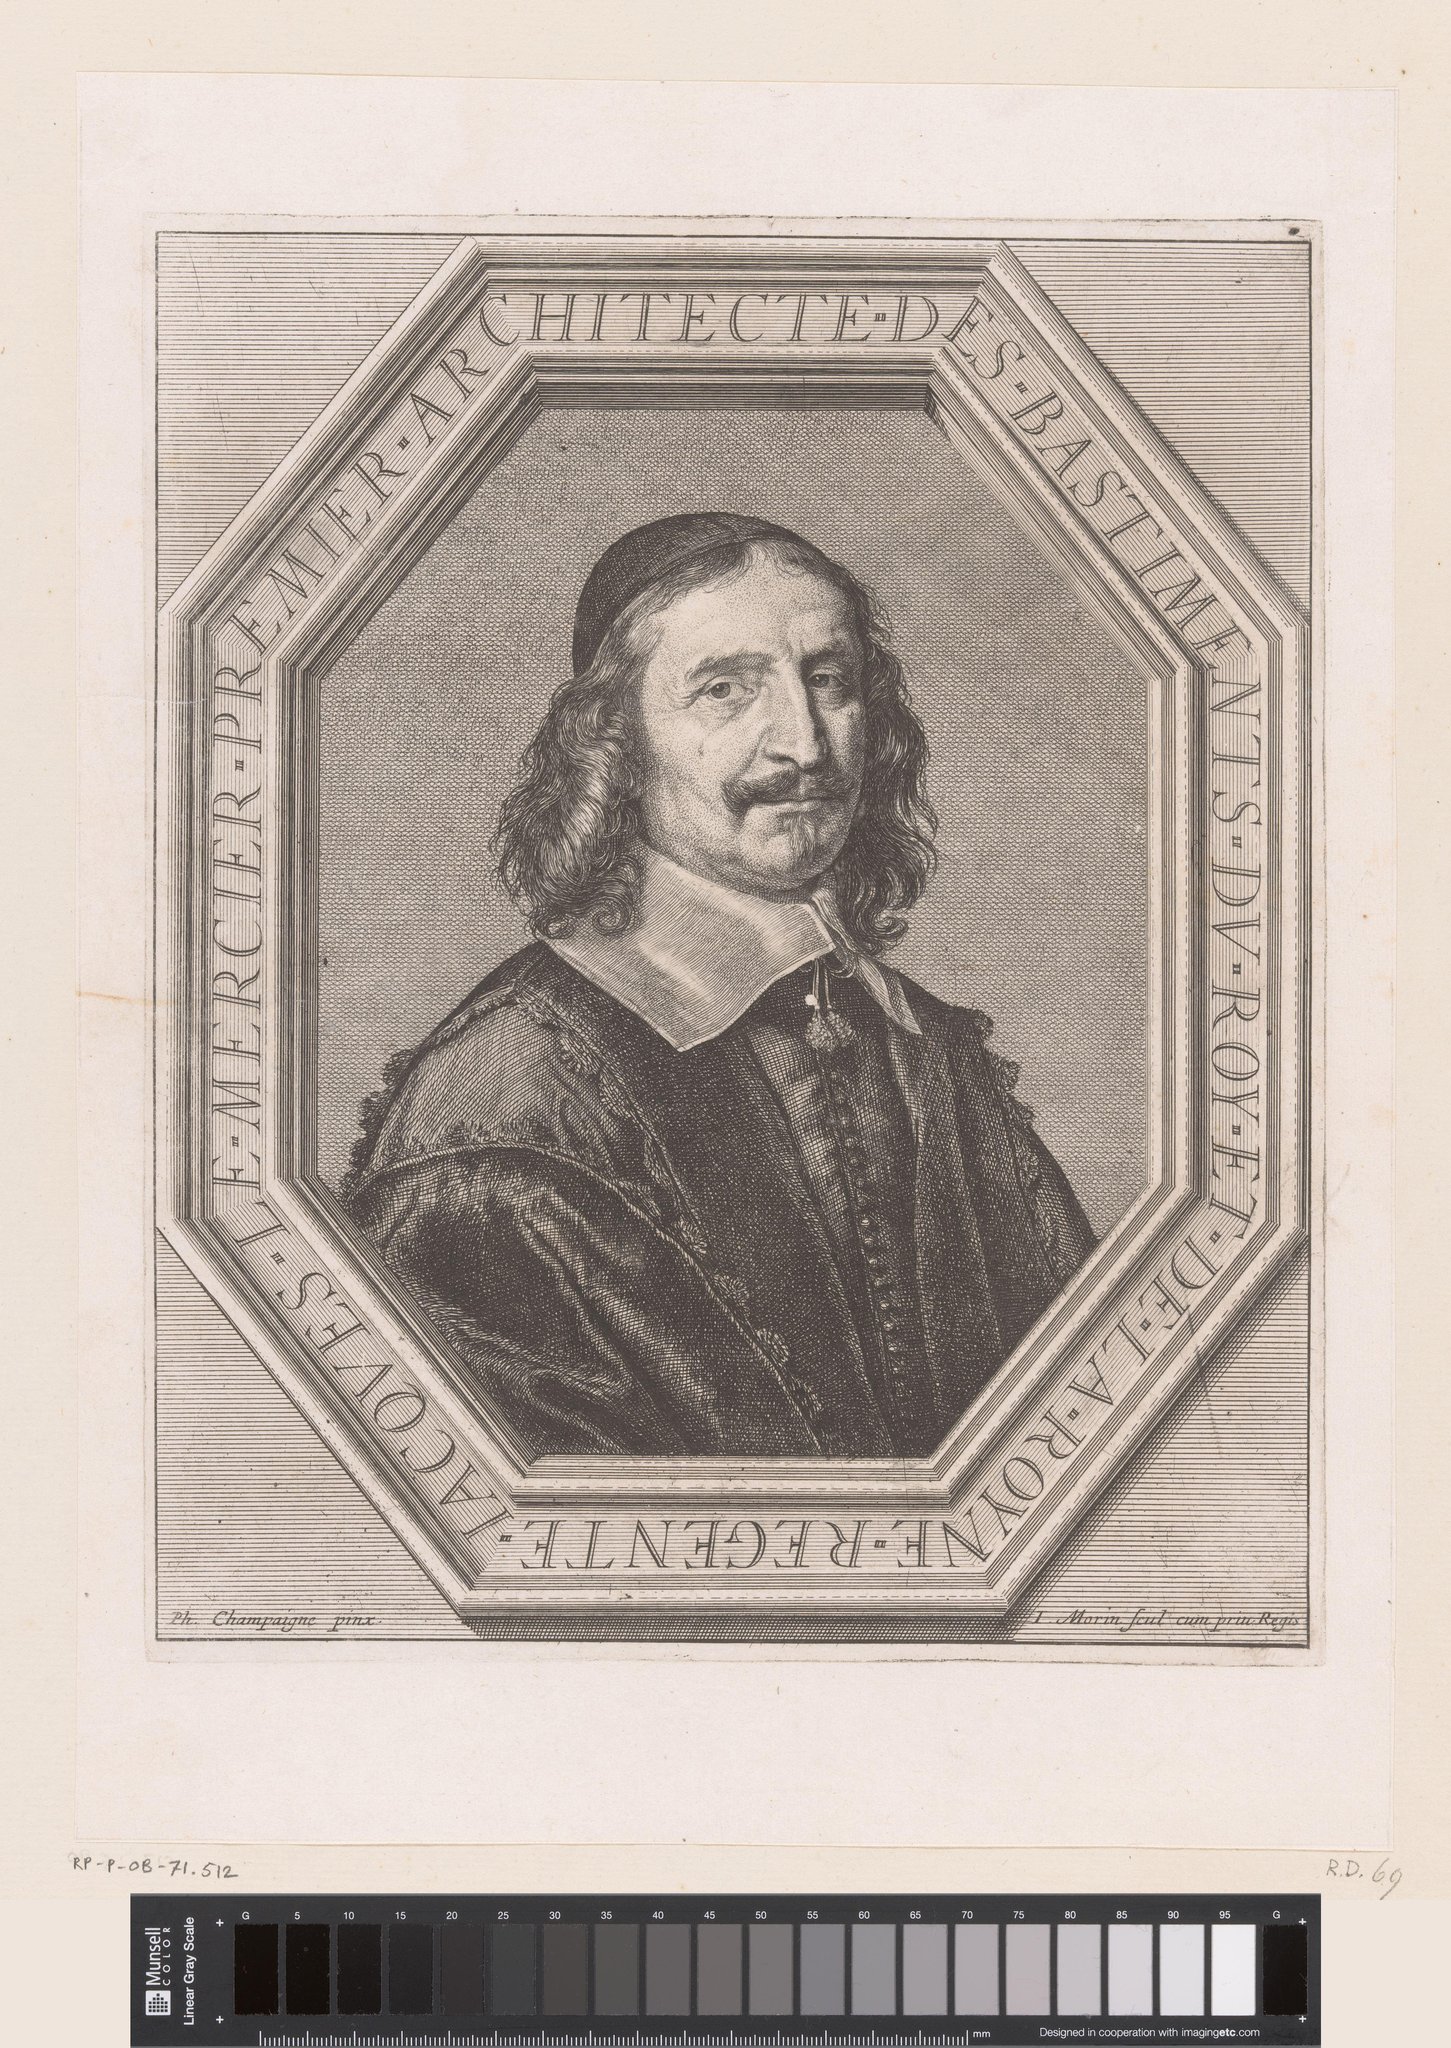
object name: print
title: Portret van Jacques Lemercier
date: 1640-1650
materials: paper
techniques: engraving, etching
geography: france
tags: paris, historical persons, portrait, self-portrait of architect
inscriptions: collector's mark: Lugt 2228